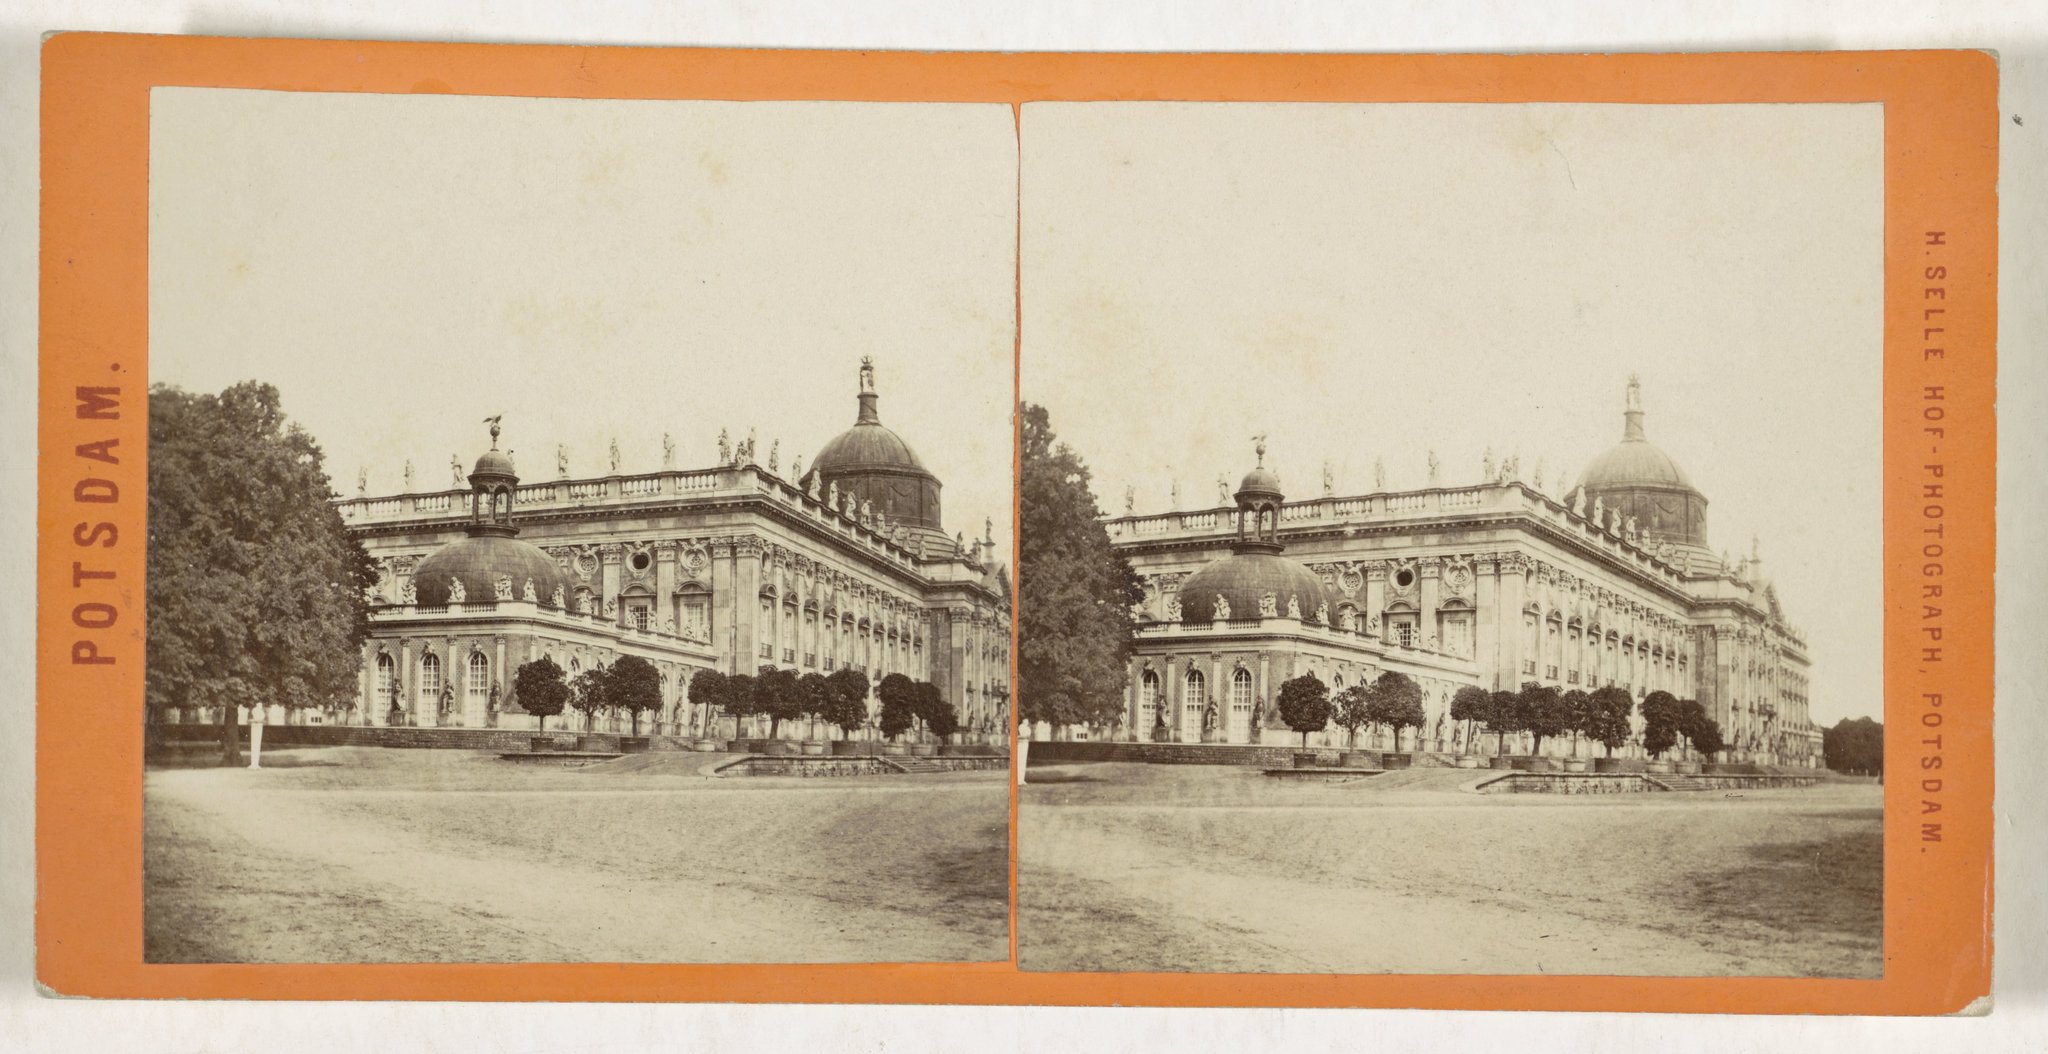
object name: stereograph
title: Das Neue Palais von Südost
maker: hermann selle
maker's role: fotograaf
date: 1860-1880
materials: cardboard, paper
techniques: albumen print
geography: neues palais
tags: palace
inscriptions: inscription: ‘Man übersieht in perspectivischer Ansight (...)’, number: ‘No 30.’